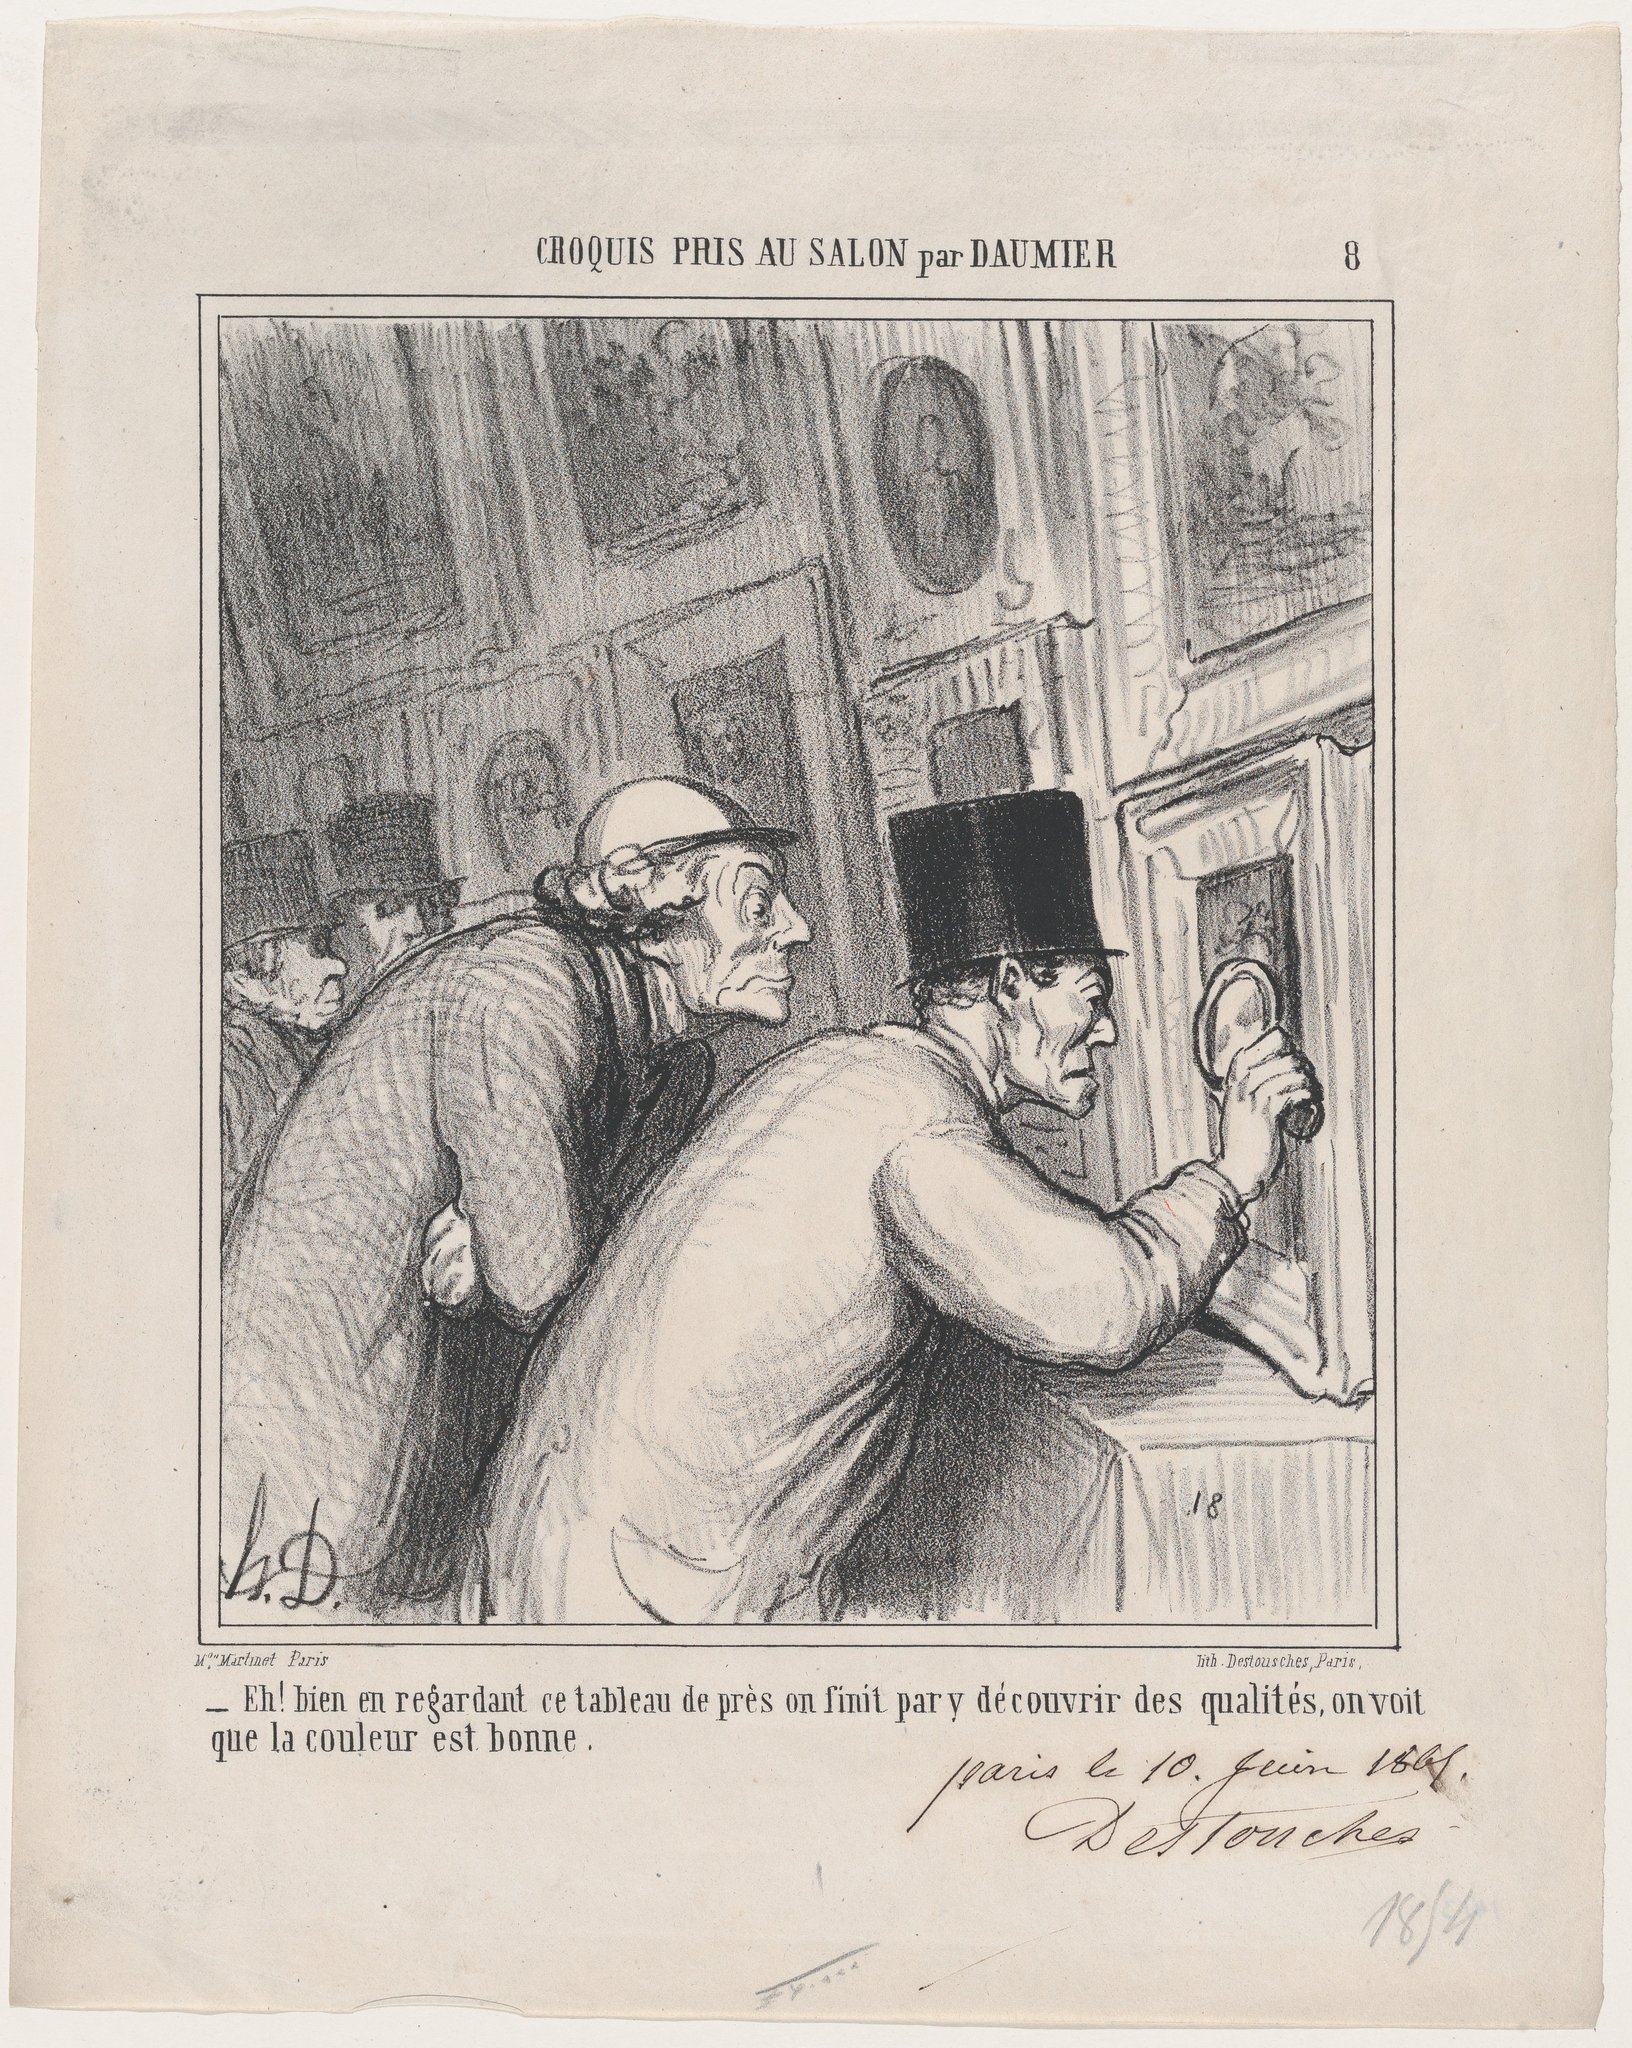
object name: print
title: Well, if you look very closely, you might end up finding some quality! The color seems to be good, from 'Sketches from the Salon,' published in Le Charivari, June 16, 1865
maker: honoré daumier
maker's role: artist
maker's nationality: french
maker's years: 1808-1879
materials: ink, paper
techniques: lithograph, pen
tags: men